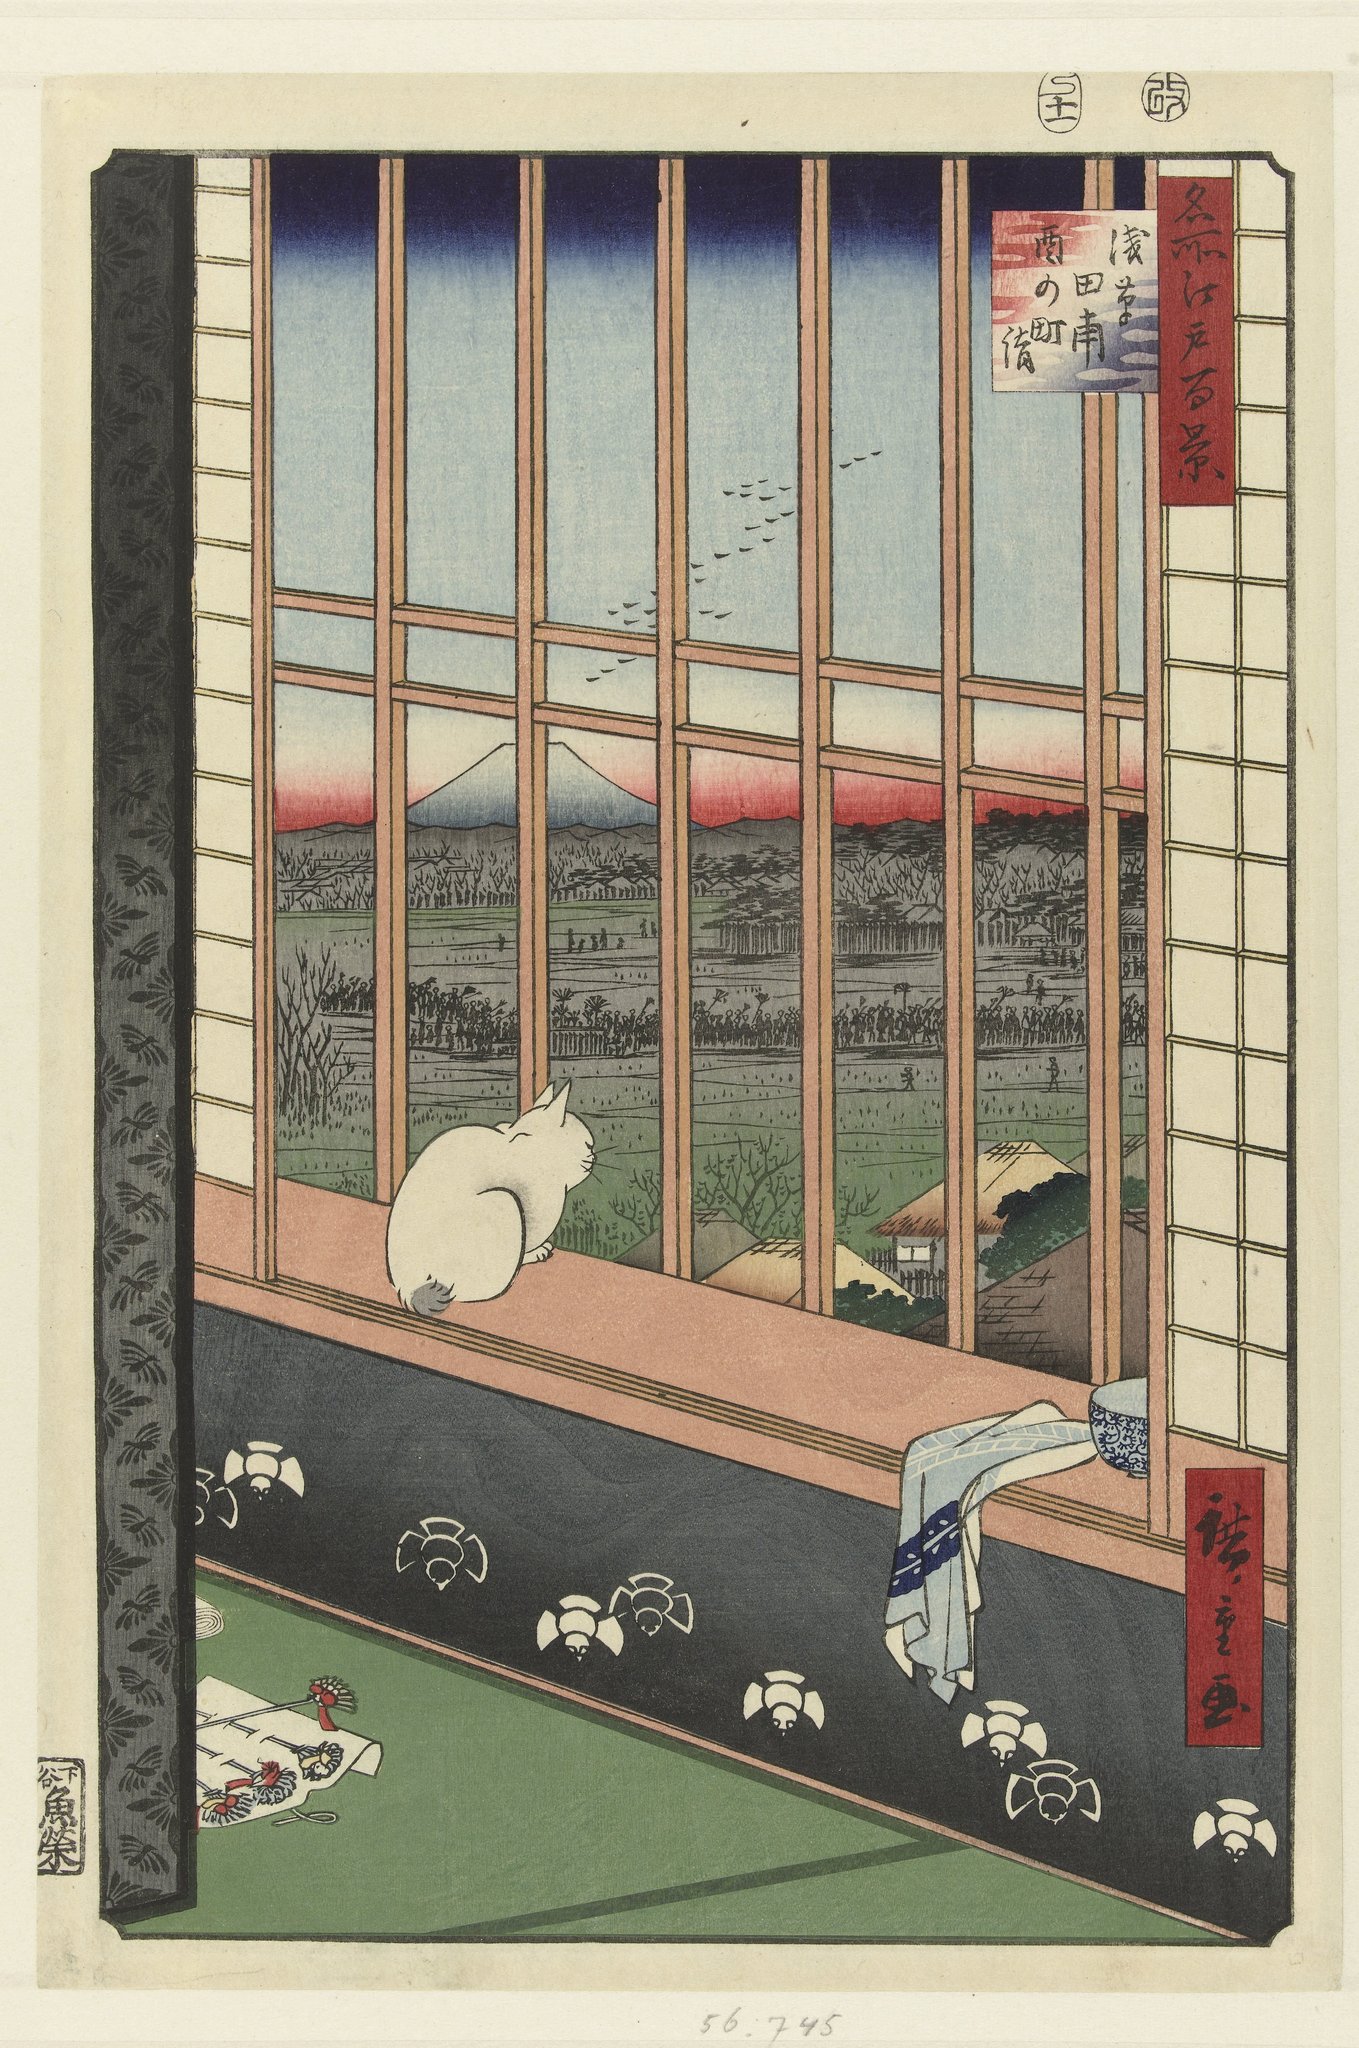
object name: print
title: Asakusa ricefields and Torinomachi festival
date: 1811-1857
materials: paper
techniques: woodcut, nishiki e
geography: tokyo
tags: cat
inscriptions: date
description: Een kat kijkt vanaf de vensterbank uit over de rijstvelden waar een stoet mensen op weg is naar een tempel. Aan de horizon is de berg Fuji zichtbaar.